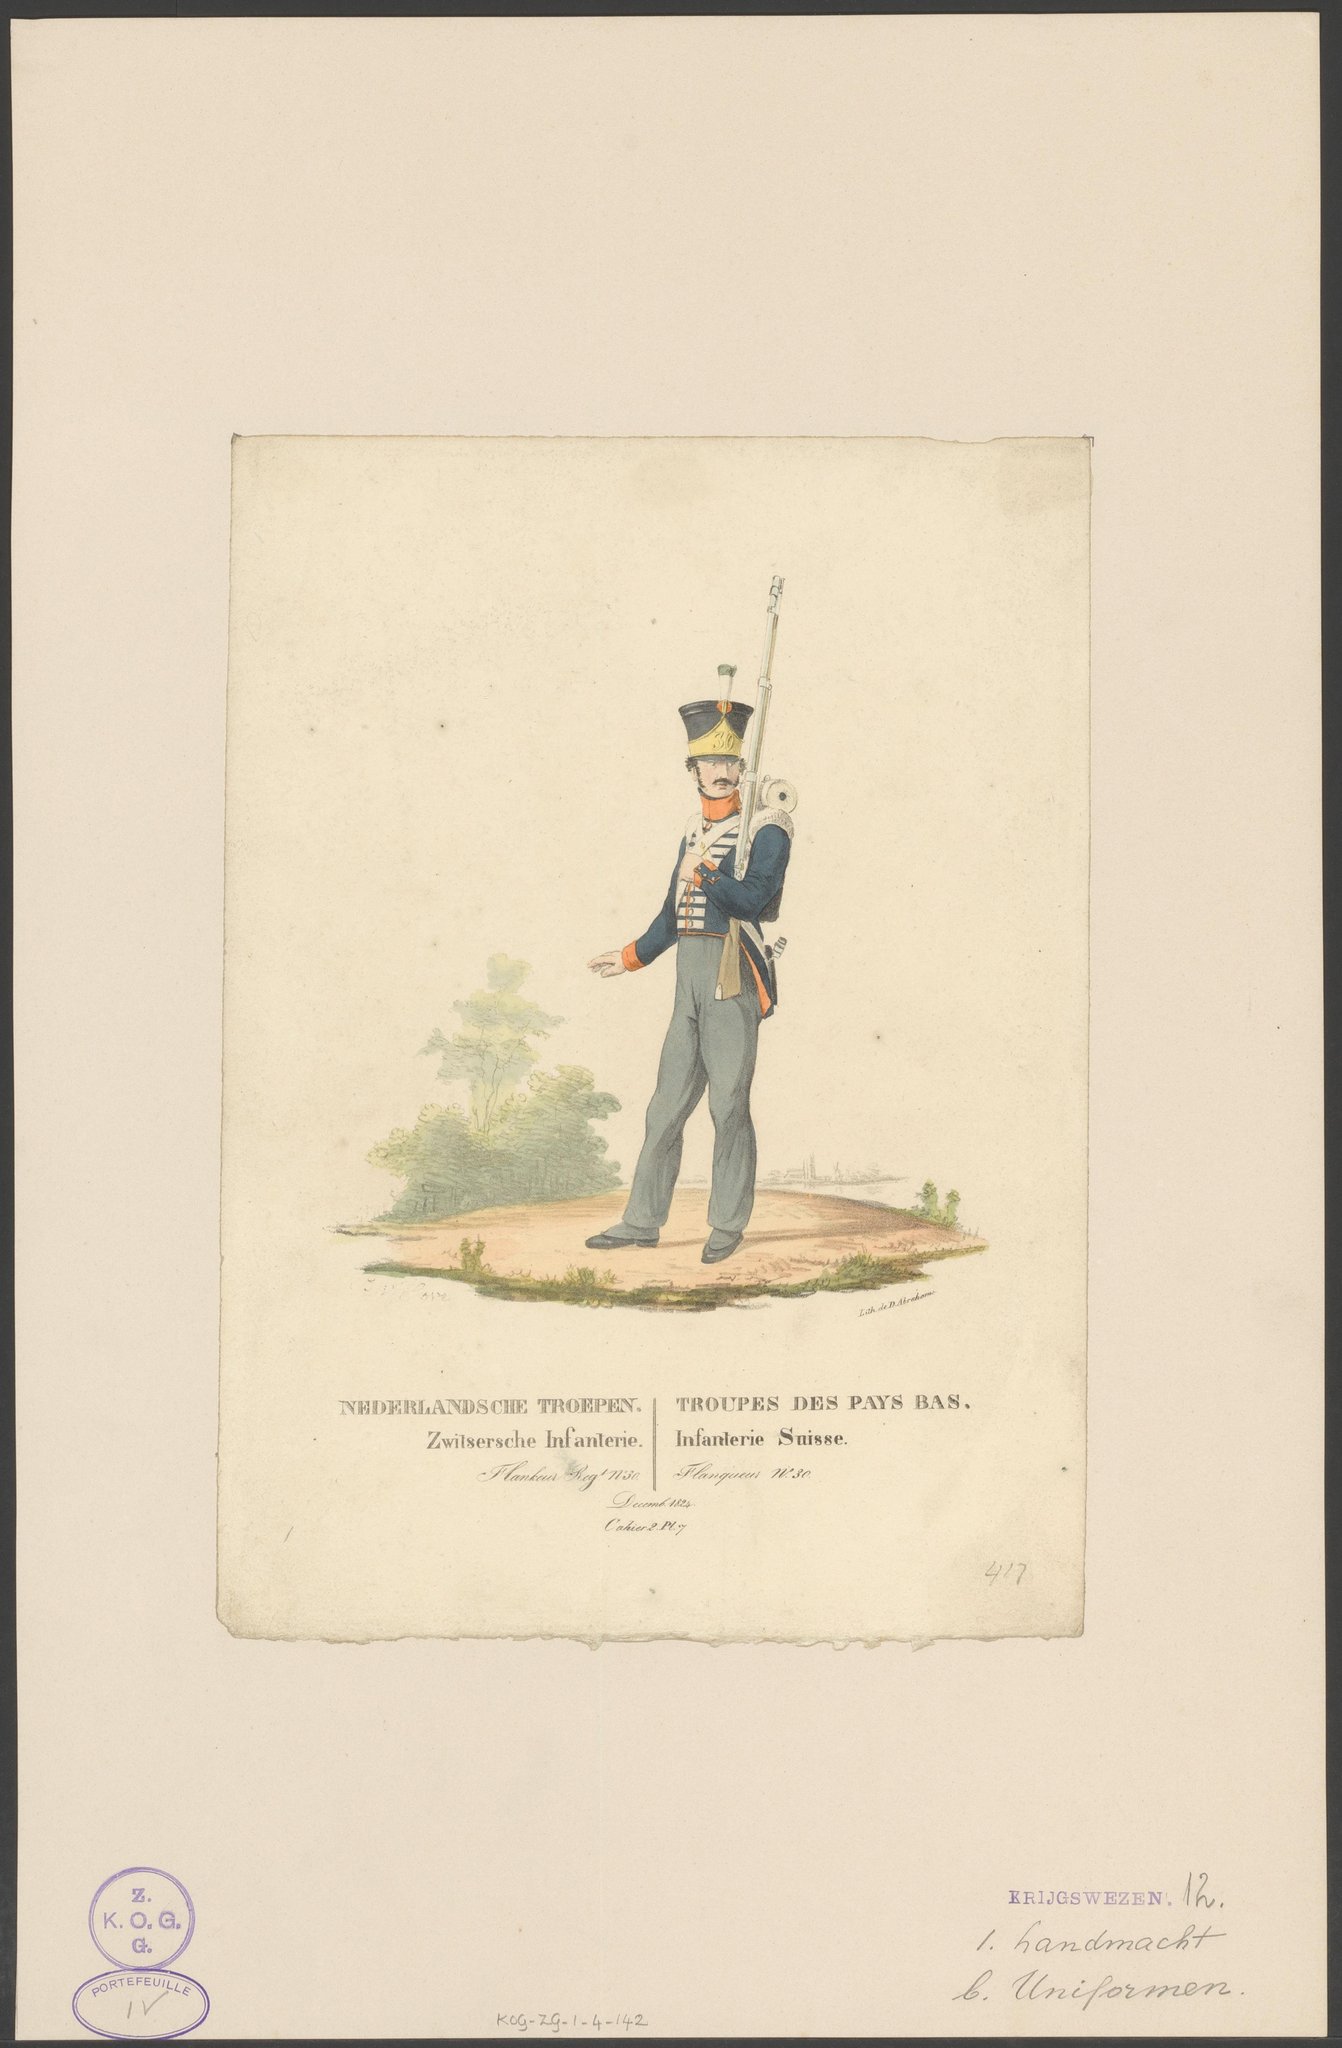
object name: print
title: Nederlandsche Troepen. Zwitsersche Infanterie. Flankeur Reg.t No. 30 / Troupes des Pays-Bas. Infanterie Suisse. Flanqueur No. 30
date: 1812-1824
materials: paper, watercolor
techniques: hand coloring, lithograph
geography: netherlands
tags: (military) uniforms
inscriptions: collector's mark, collector's mark: Lugt 1641